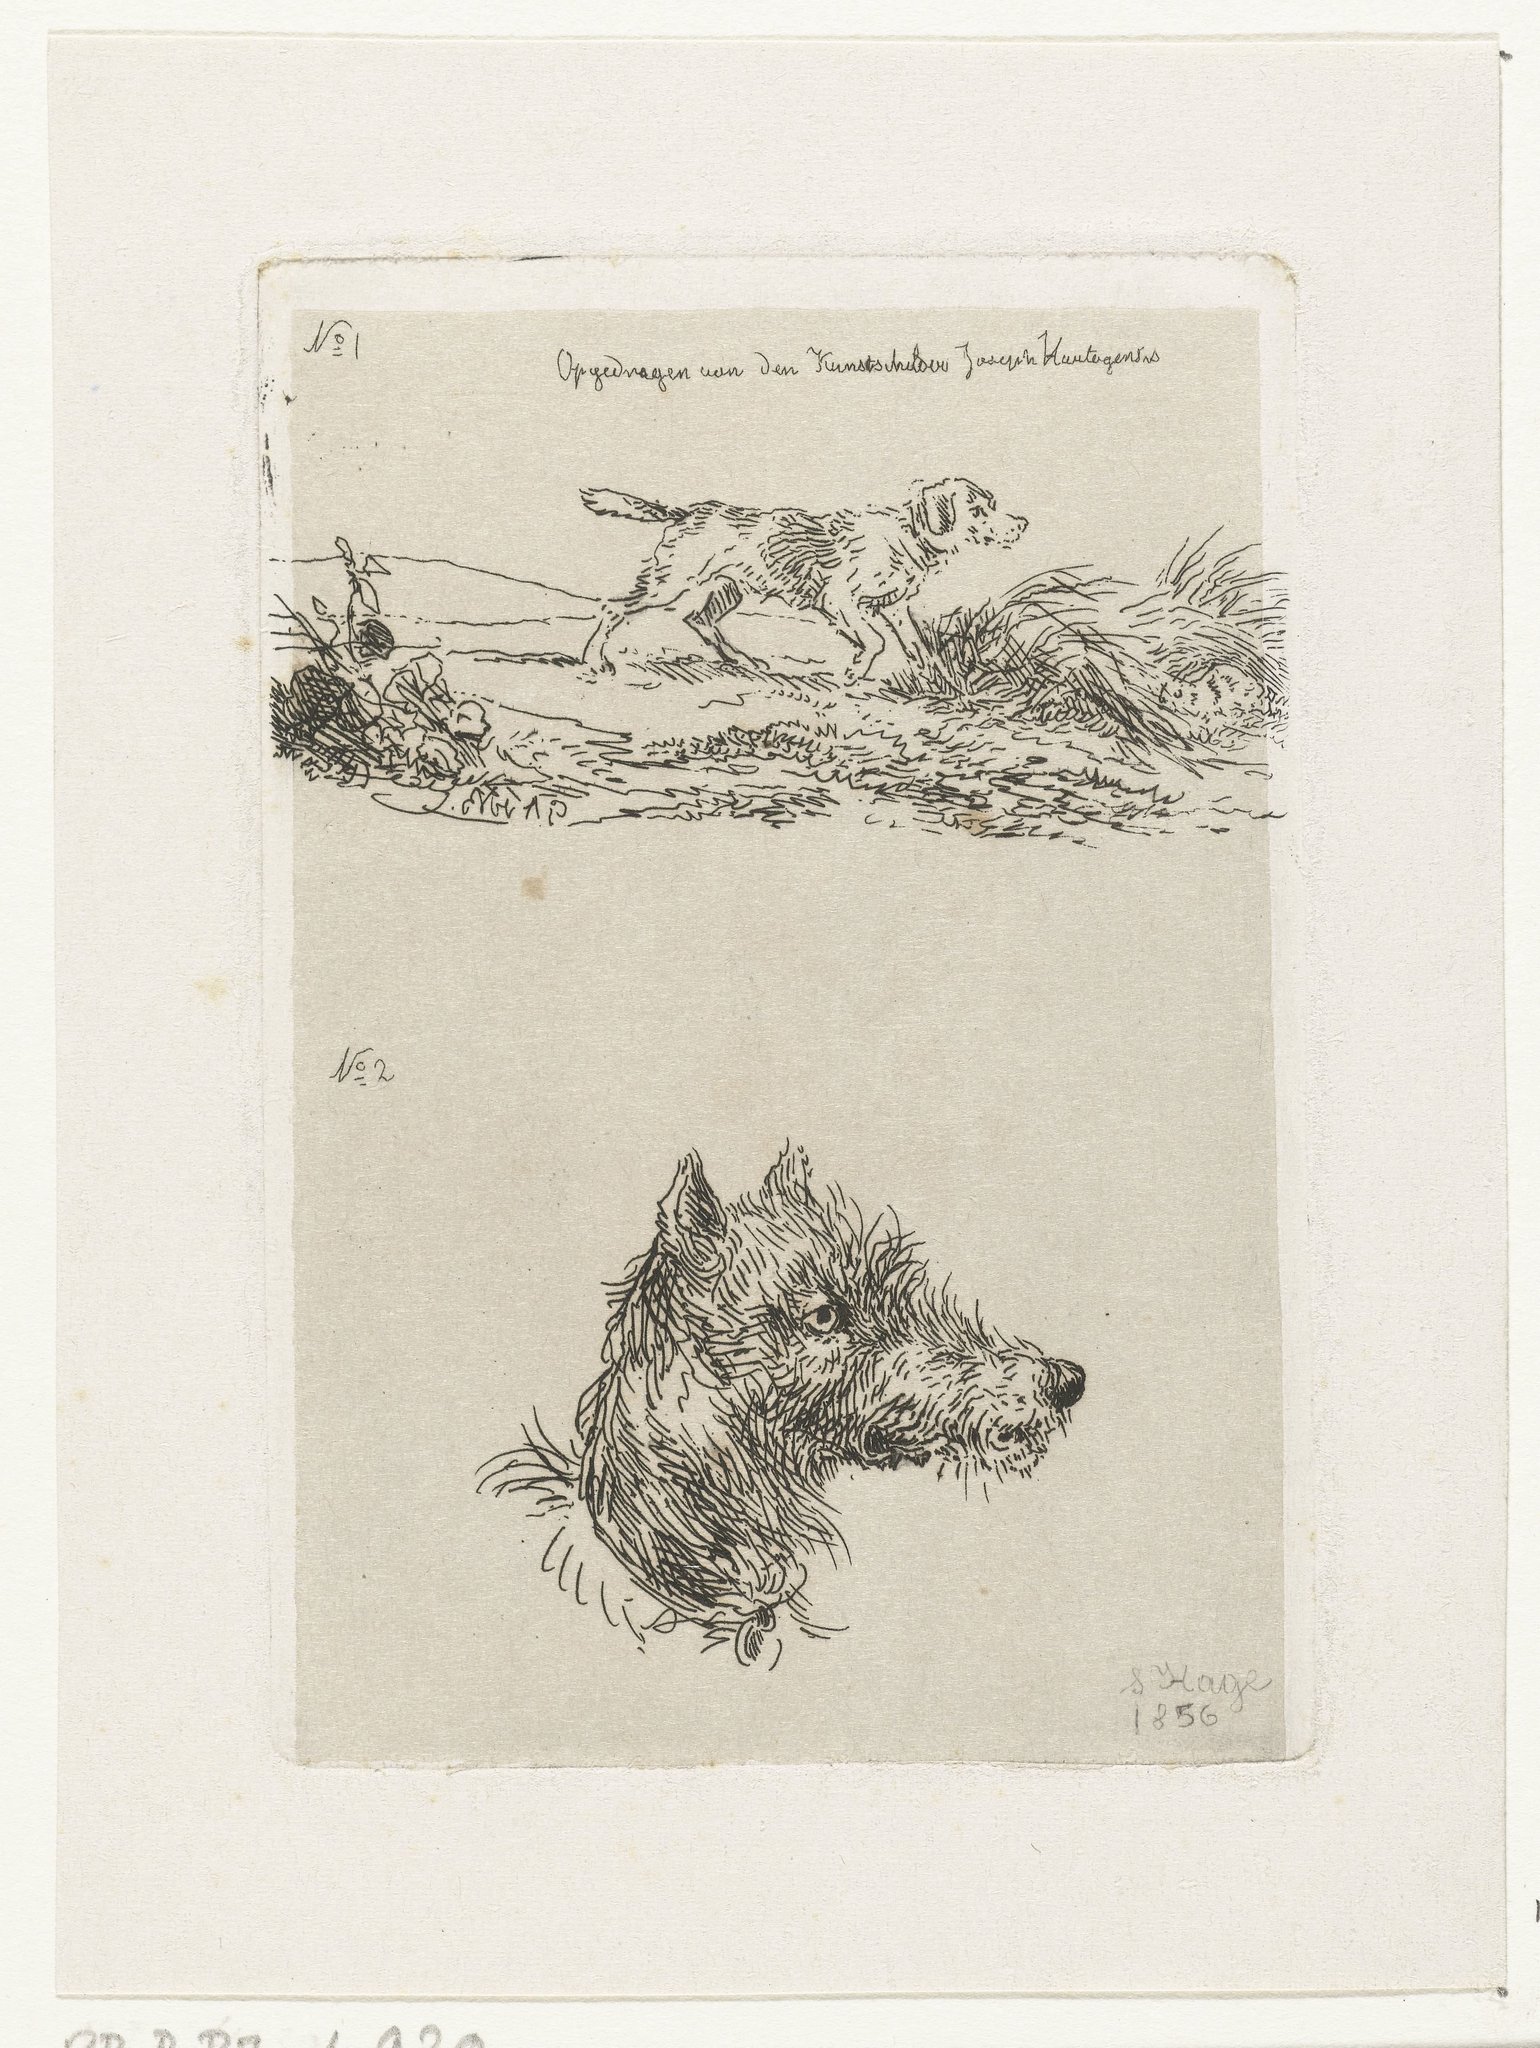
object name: print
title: Hondekop en hond in landschap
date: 1856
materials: paper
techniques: etching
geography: the hague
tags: dog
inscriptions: collector's mark: Lugt 2228